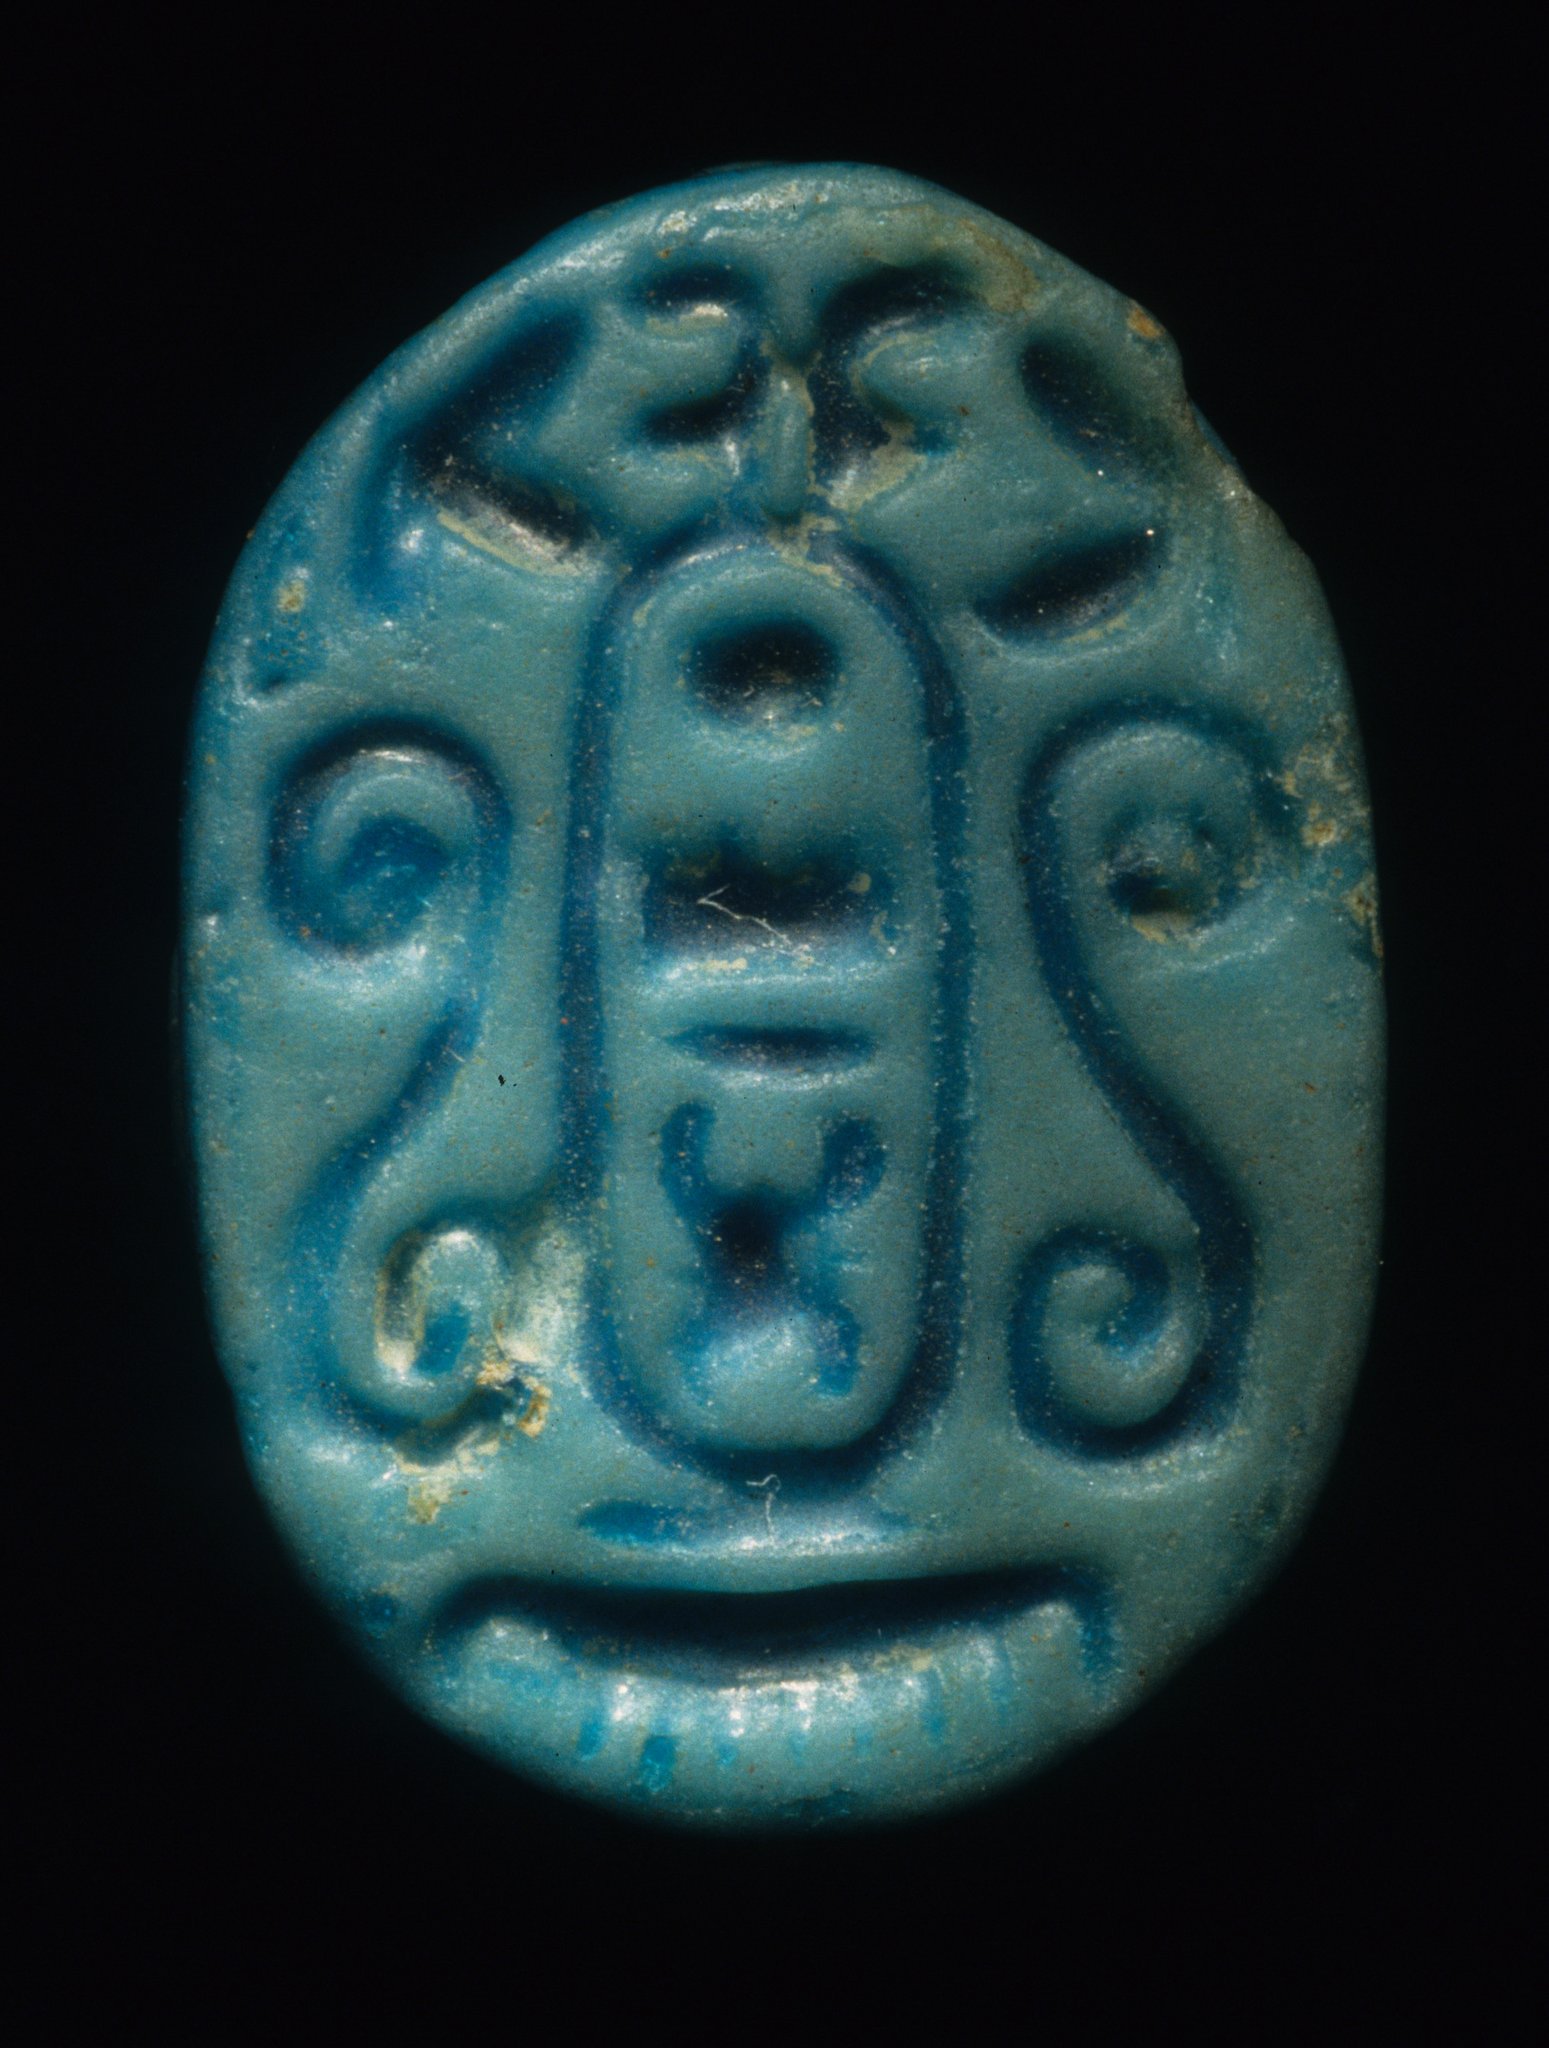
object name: scarab, thutmose iii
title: Scarab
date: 1479-1425 BCE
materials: faience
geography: egypt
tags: scarabs